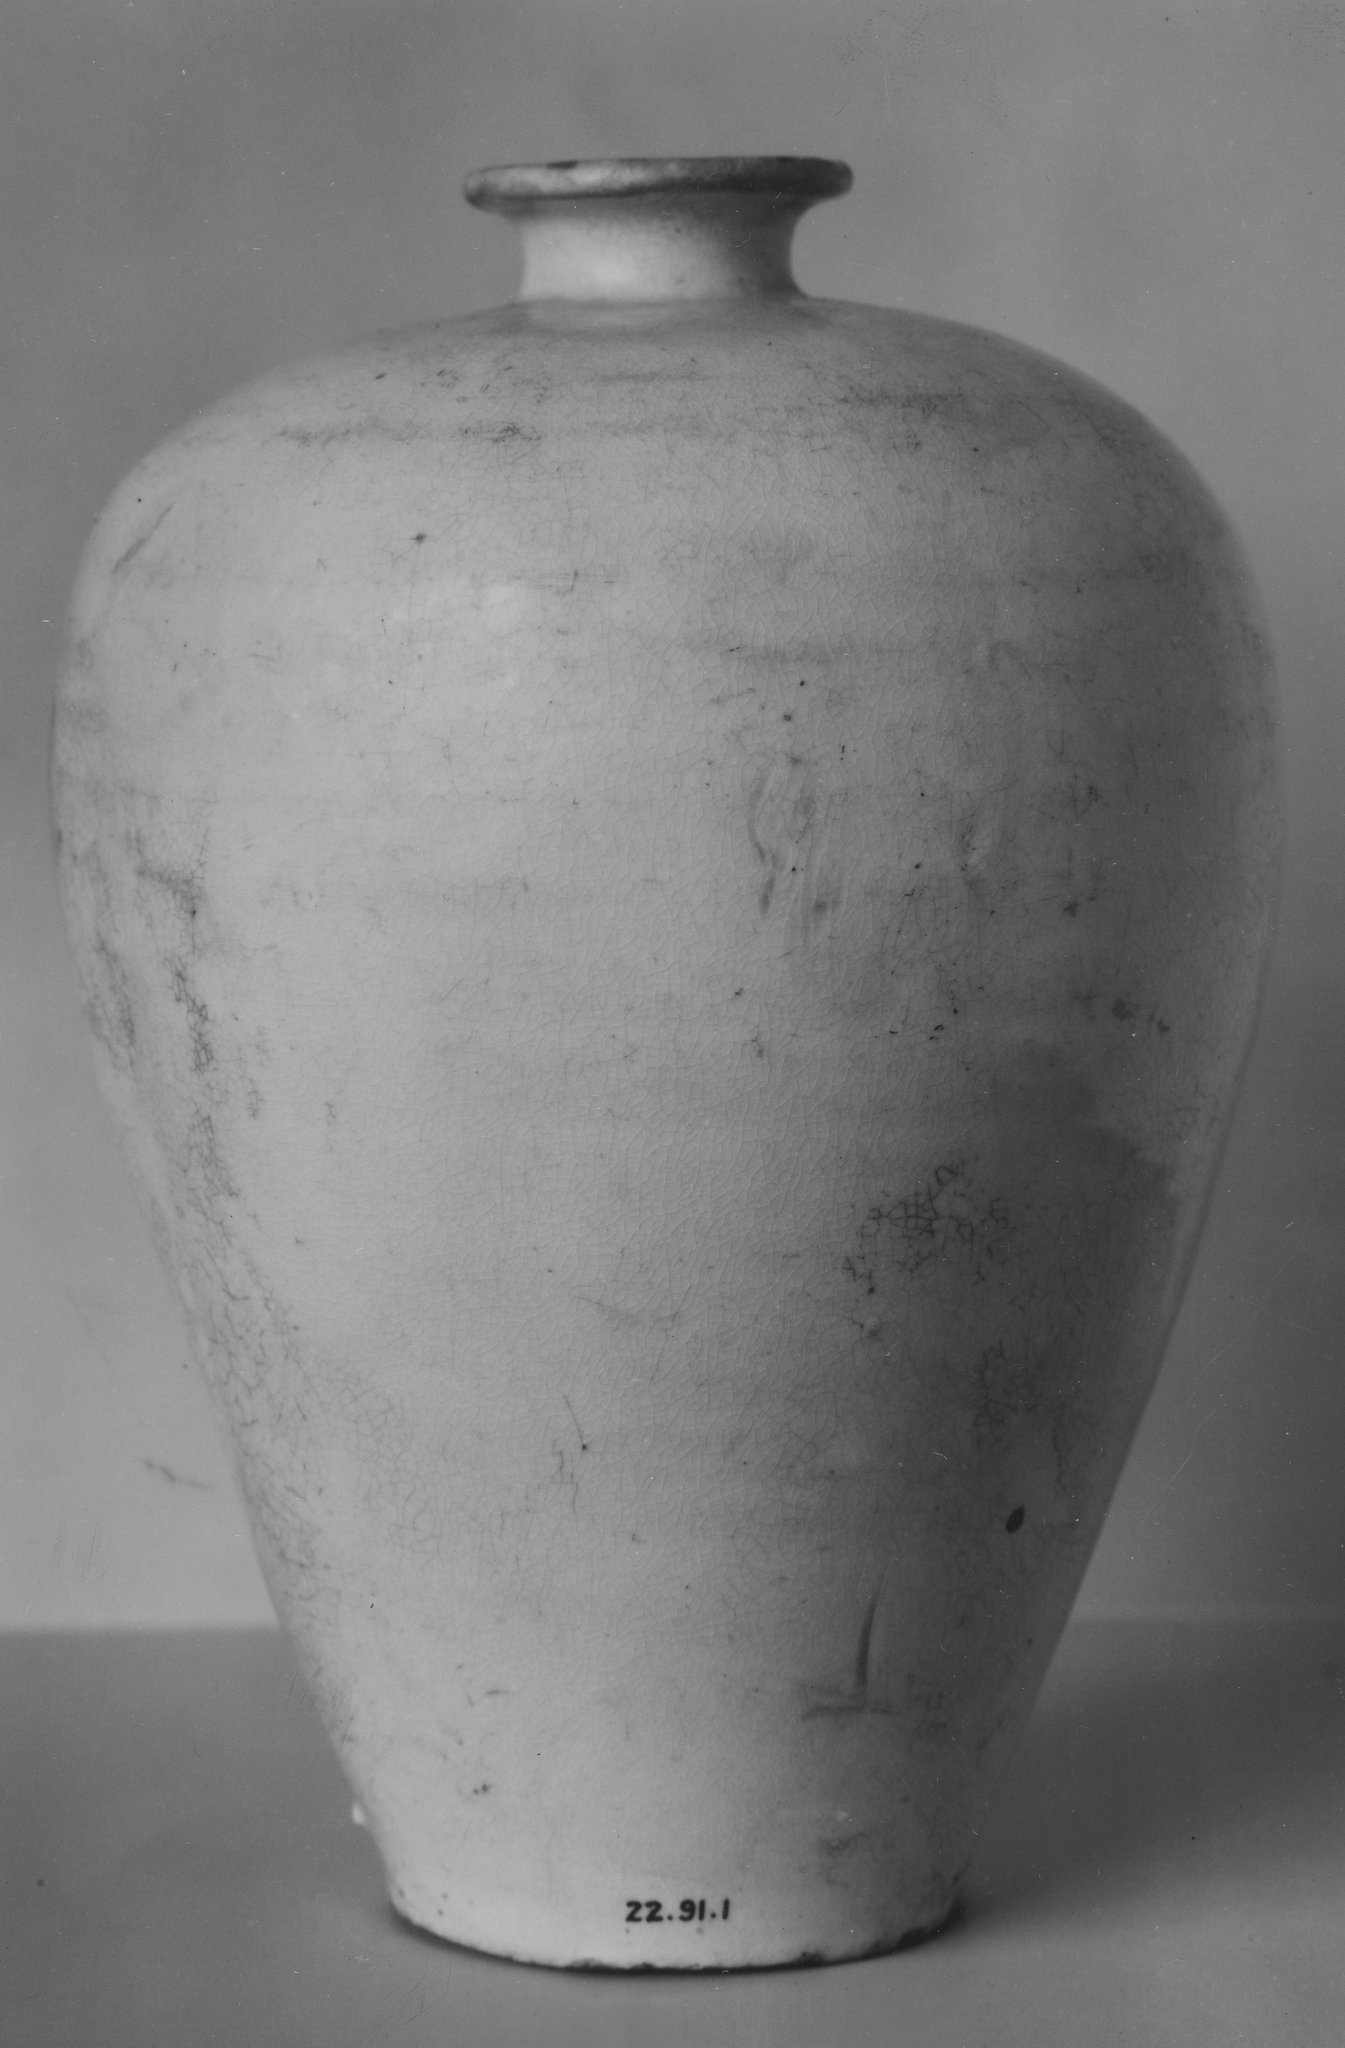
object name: jar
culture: chinese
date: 960-1279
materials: pottery